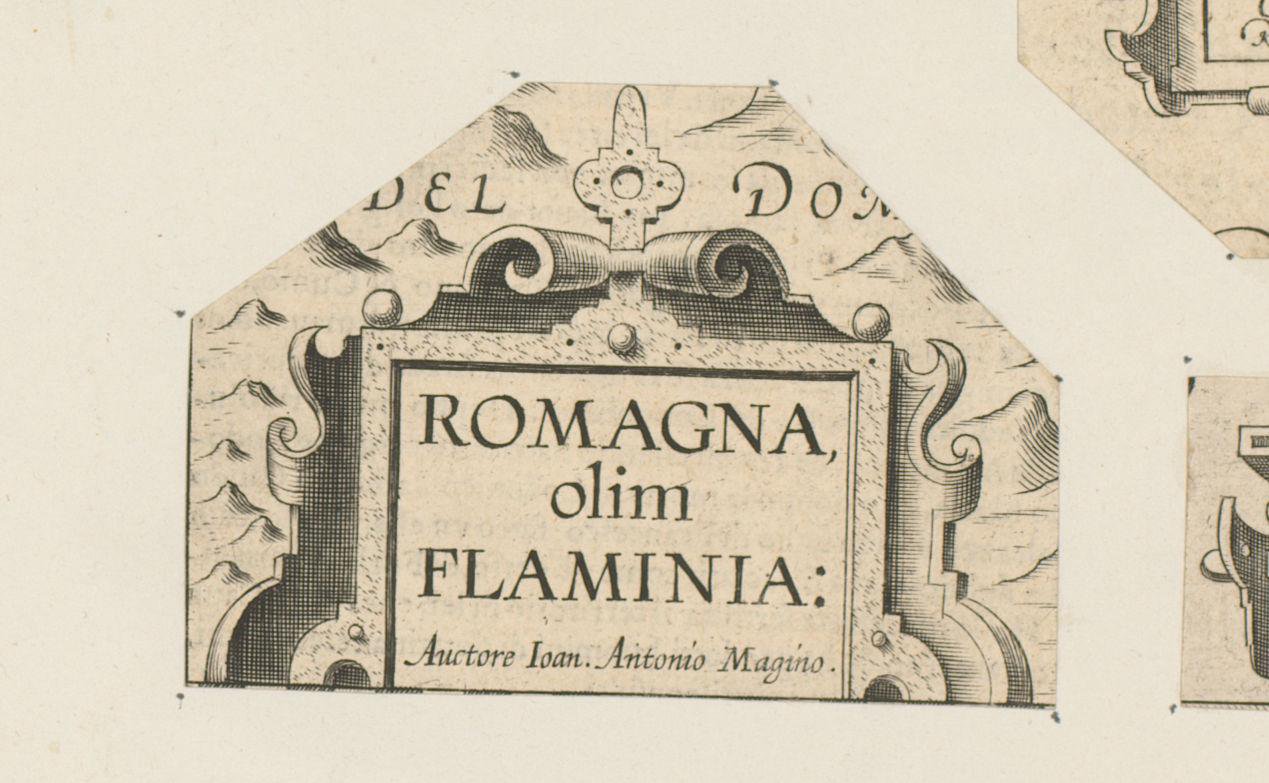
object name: print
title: Romagna, olim Flaminia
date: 1608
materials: paper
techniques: engraving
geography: antwerp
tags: scrollwork, strapwork ~ ornament, ornament ~ cartouche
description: Rechthoekige cartouche met rolwerk. De cartouche is een fragment van een kaart van Romagna. De prent maakt deel uit van een album.